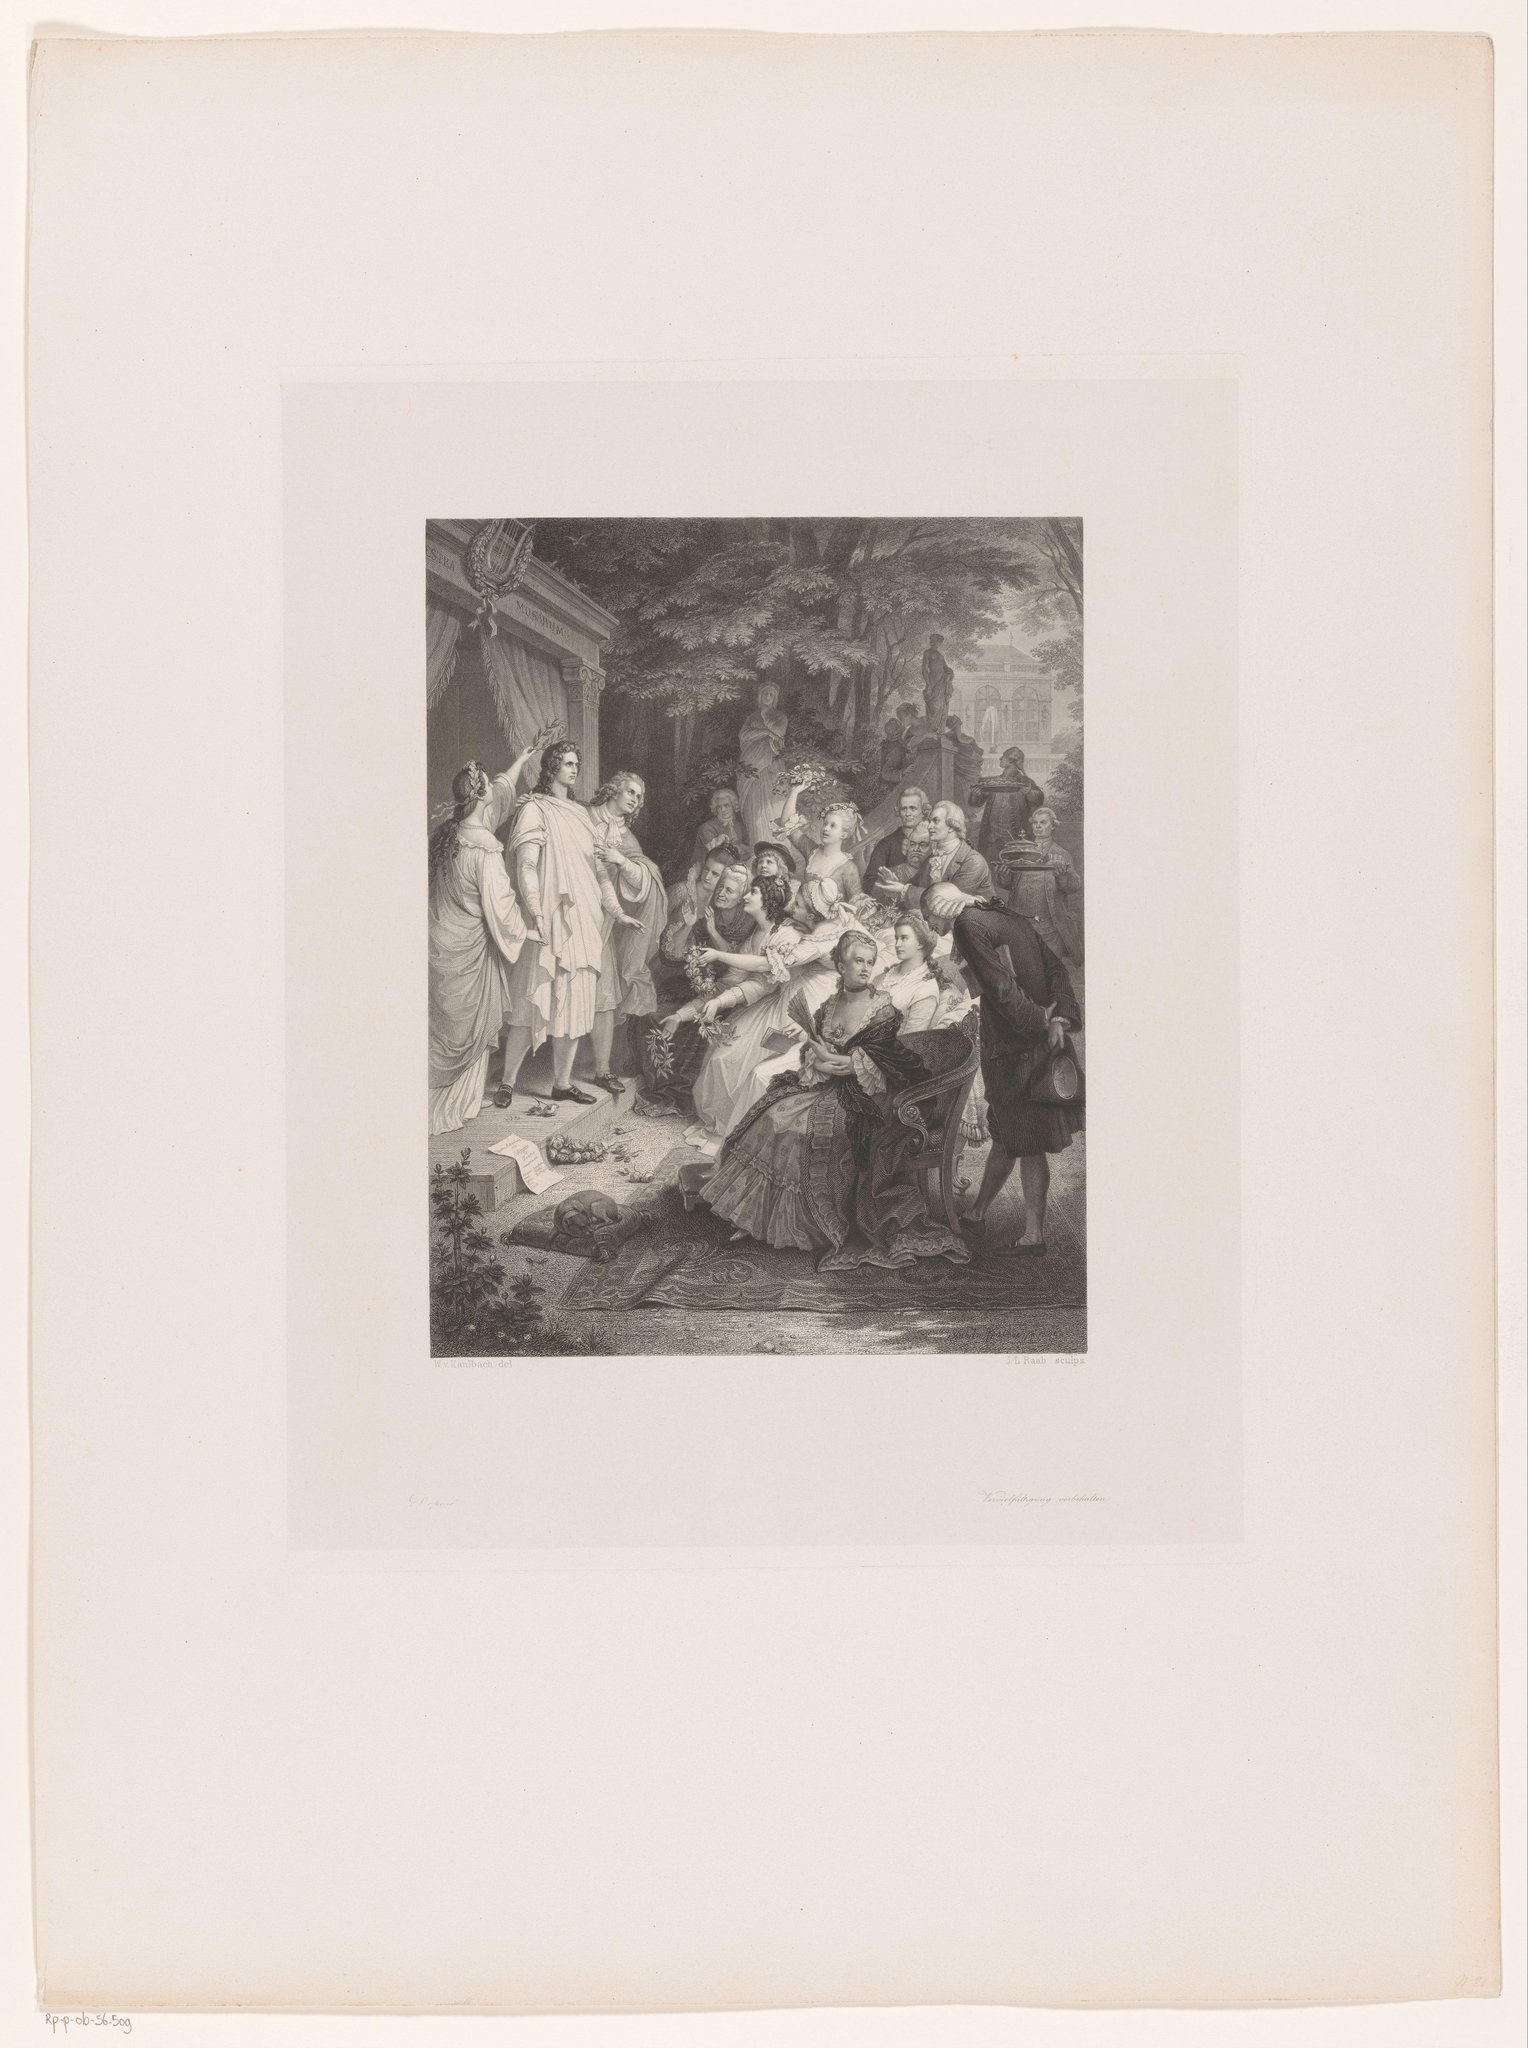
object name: print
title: Toneelspeler wordt gelauwerd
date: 1864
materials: paper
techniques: etching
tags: honouring the artist with laurel wreath, group of actors, troupe; actors on the stage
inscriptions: : ‘Deposé’, collector's mark: Lugt 2228